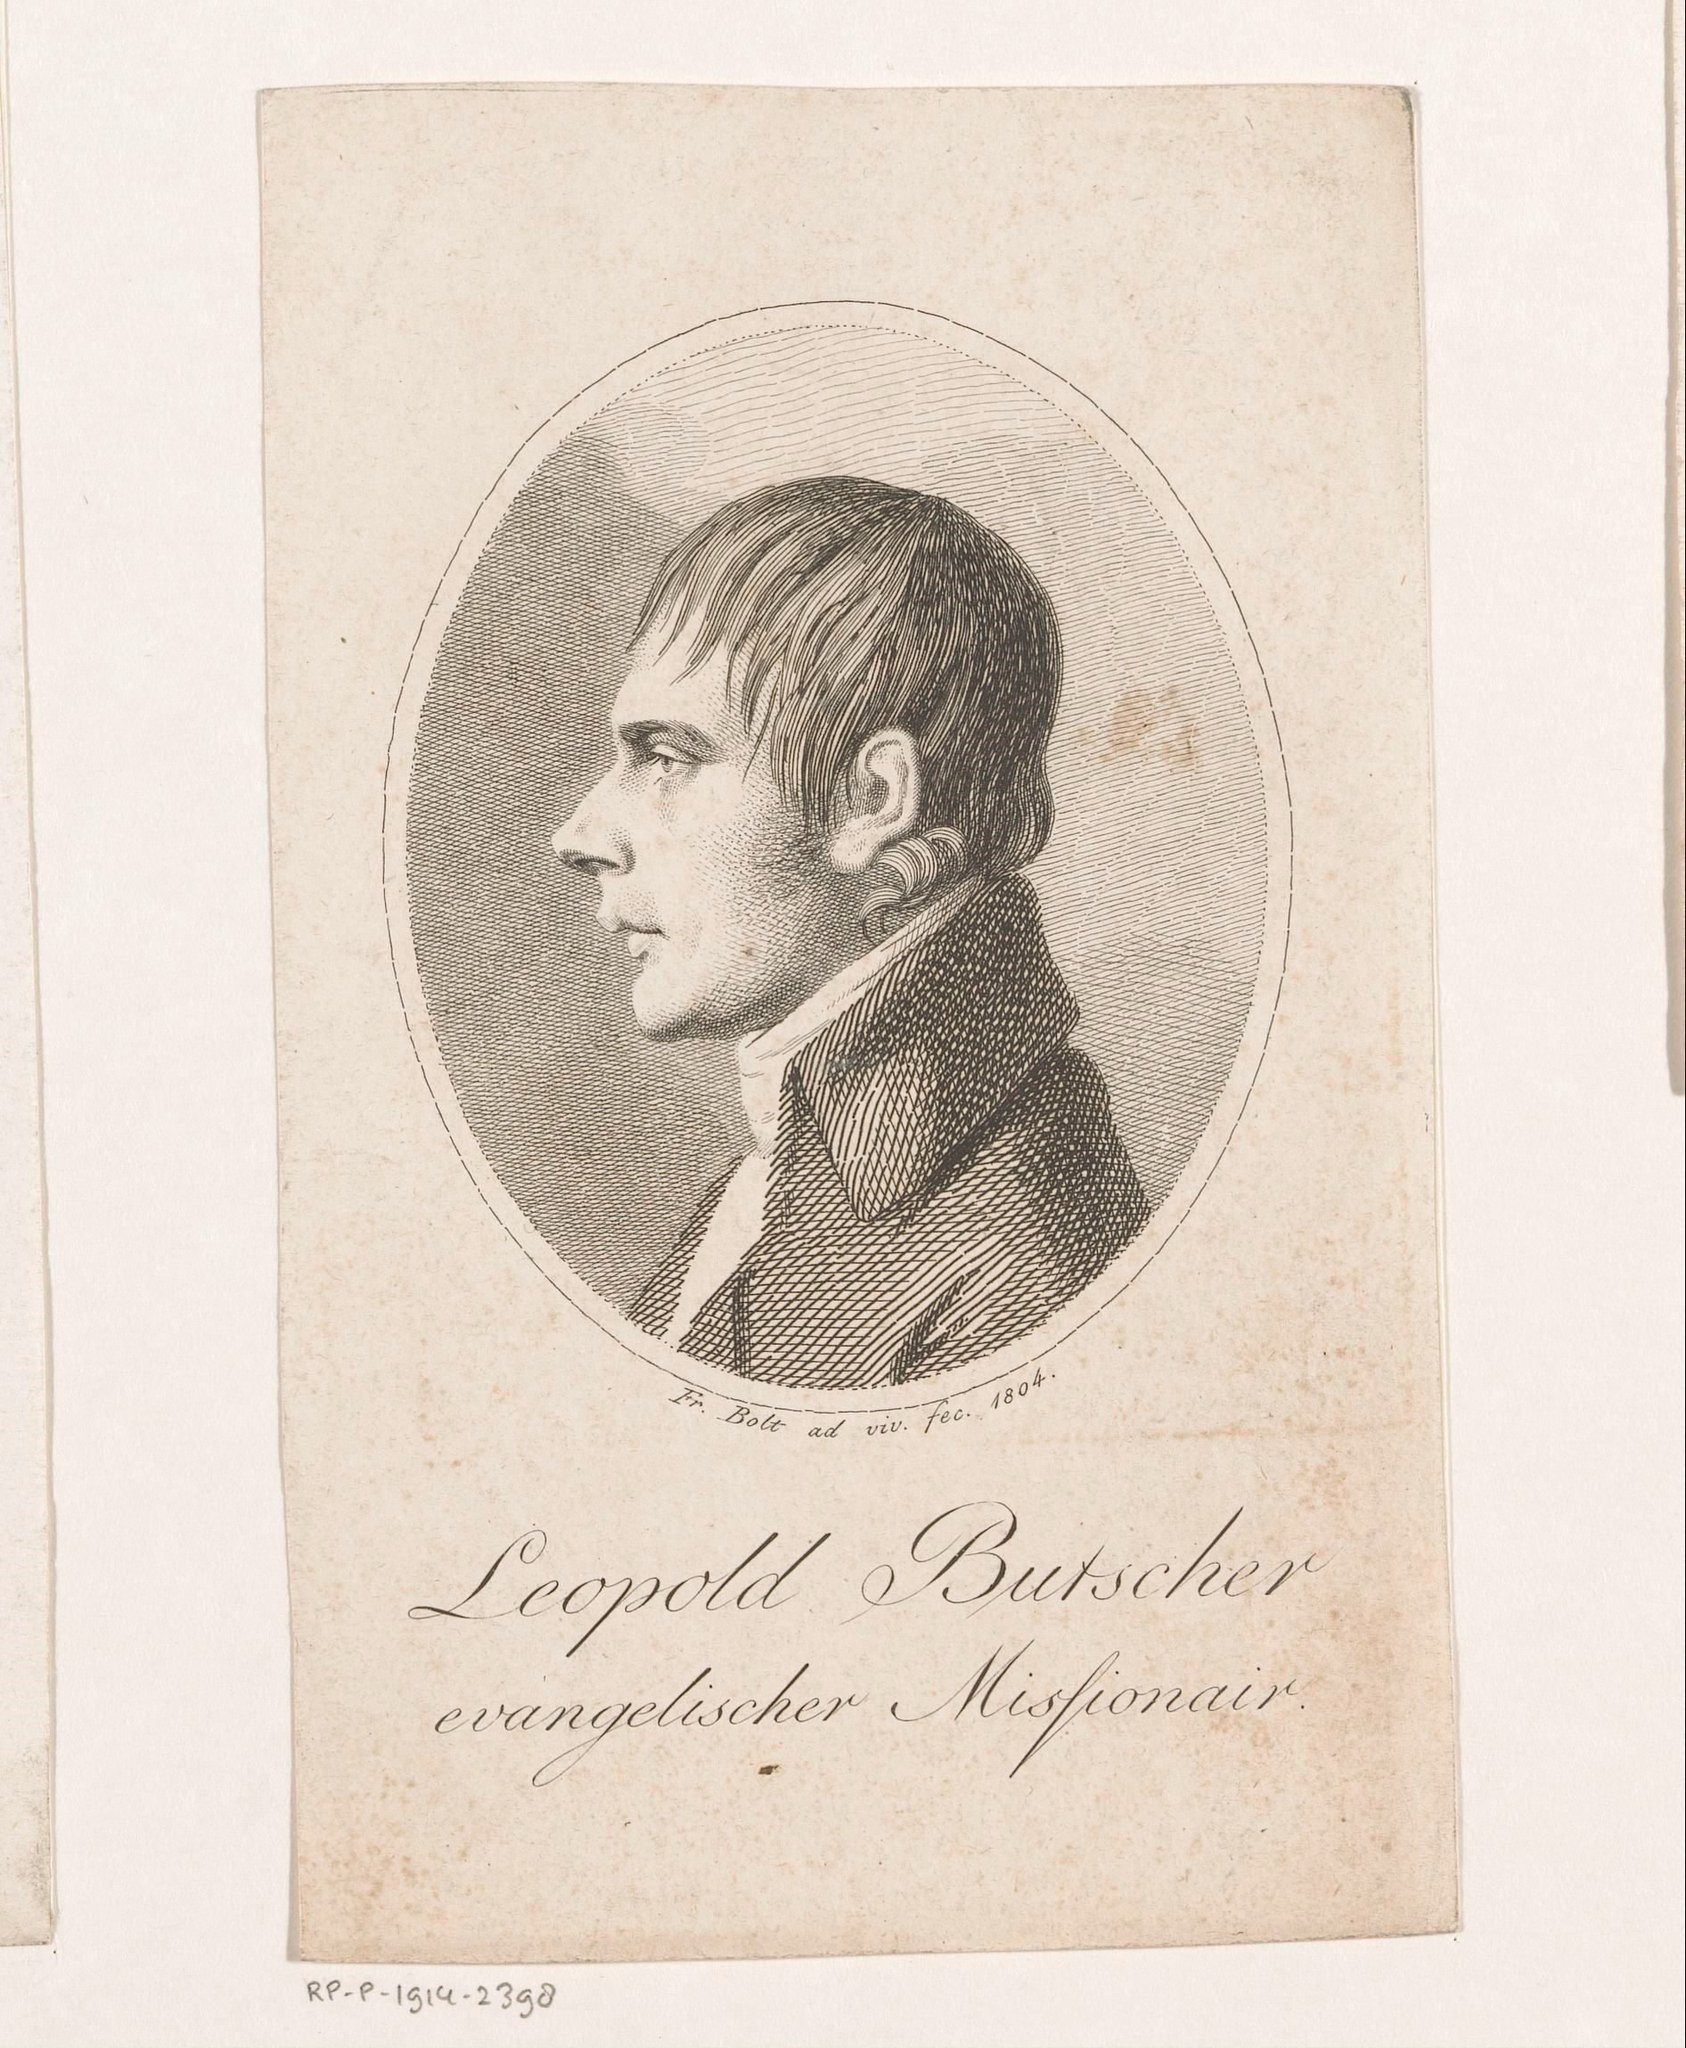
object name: print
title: Portret van Leopold Butscher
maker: johann friedrich bolt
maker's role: print maker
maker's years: 1769-1836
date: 1804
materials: paper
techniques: etching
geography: berlin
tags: missionary, historical persons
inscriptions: collector's mark: Lugt 2228